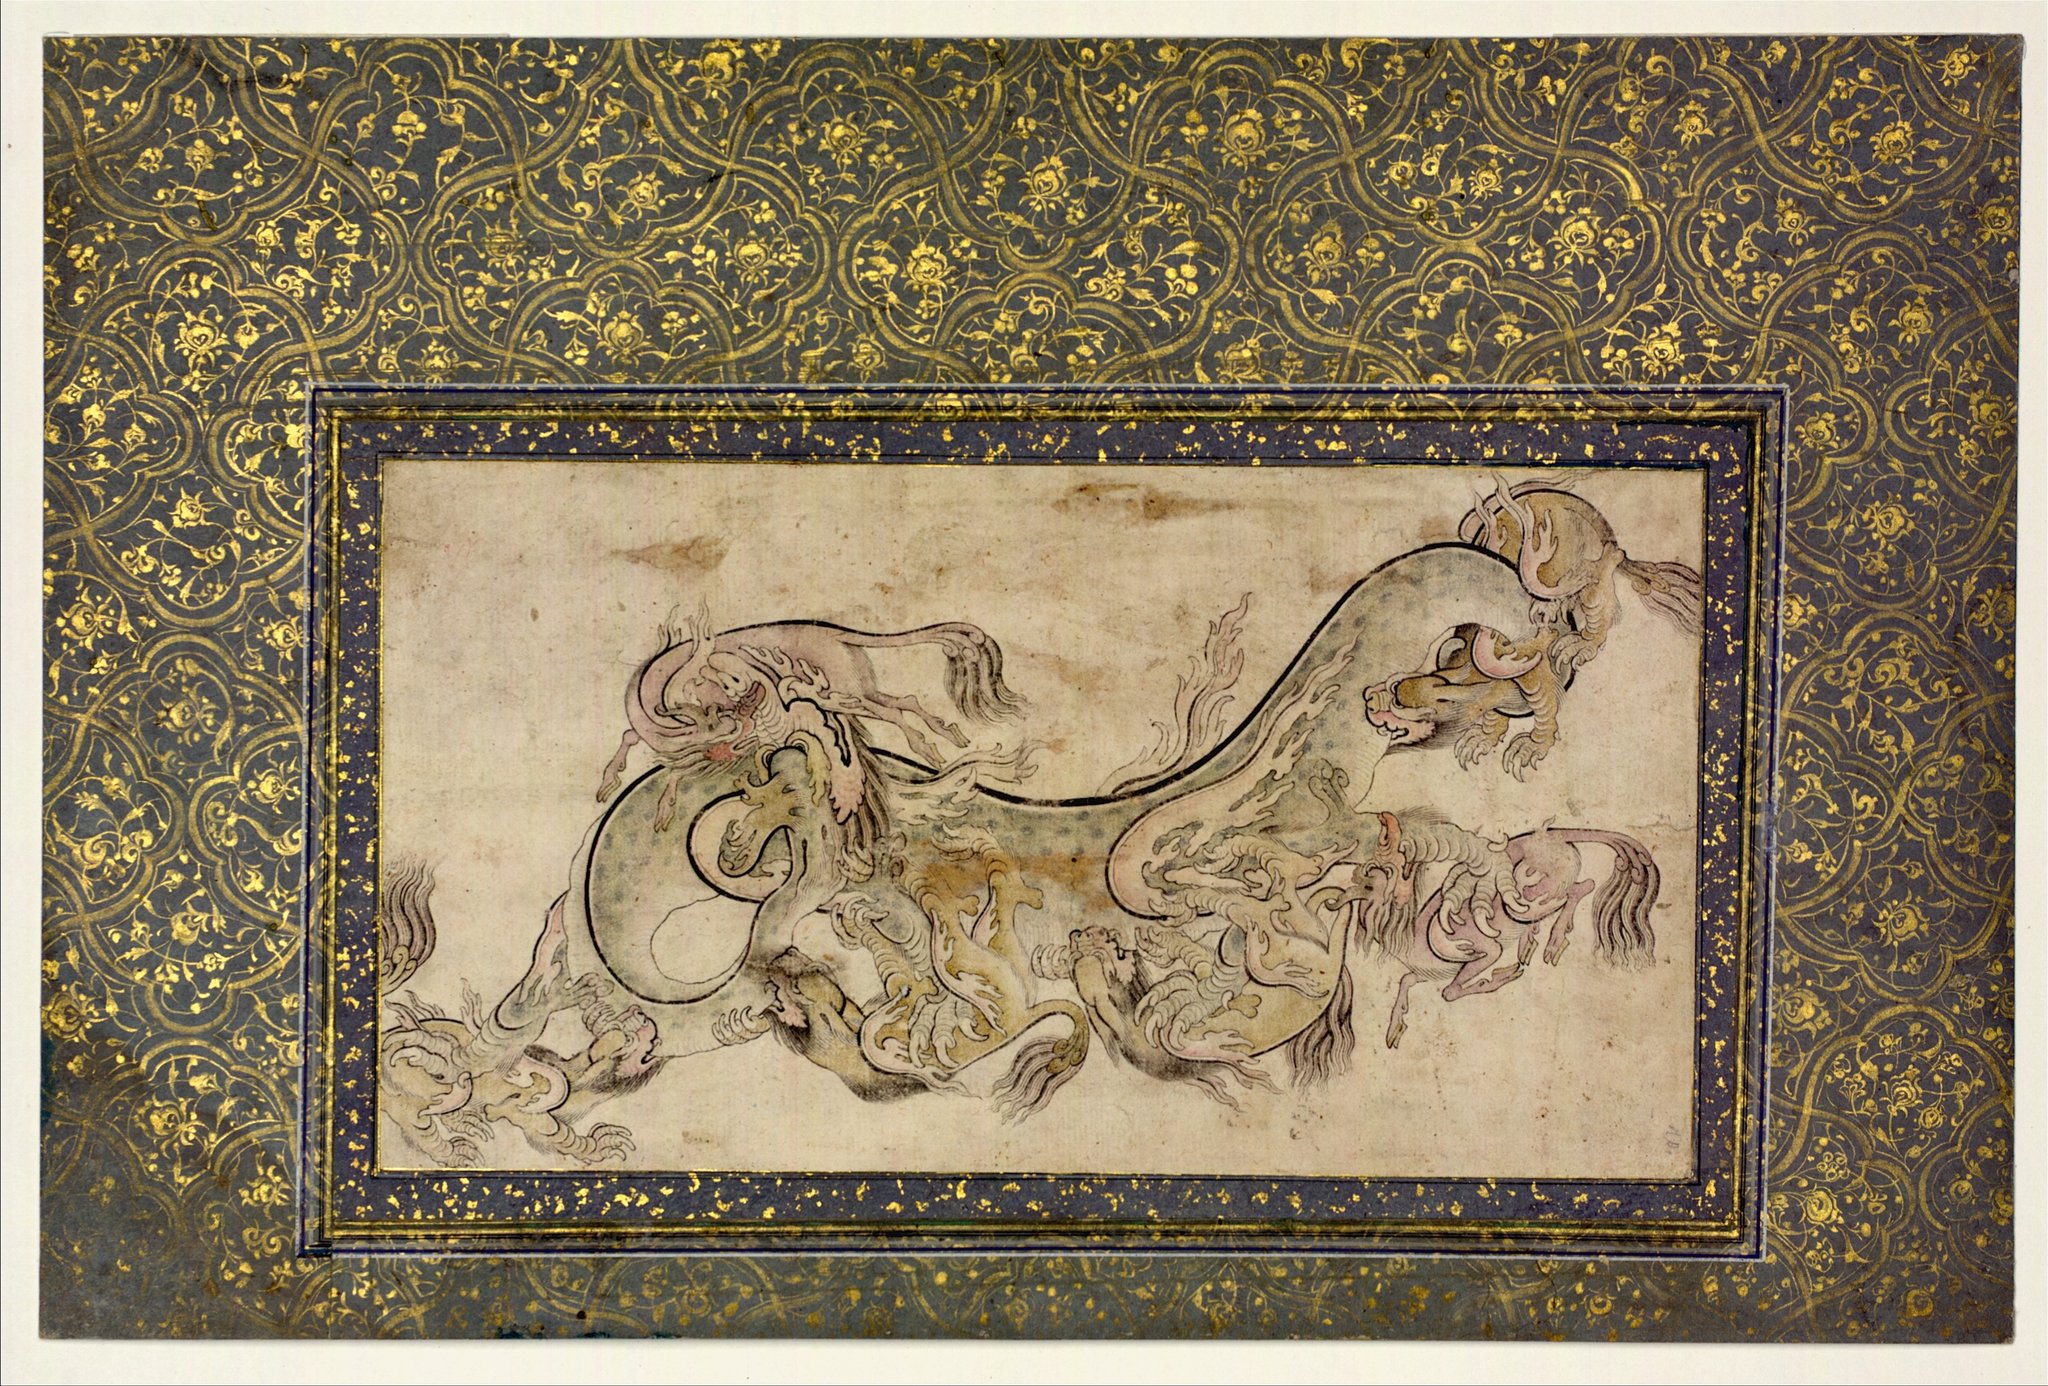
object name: illustrated single work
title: Chilins (Chinese Chimerical Creatures) Fighting with a Dragon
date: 1501-1600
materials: gold, ink, paper, watercolor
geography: turkey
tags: dragons